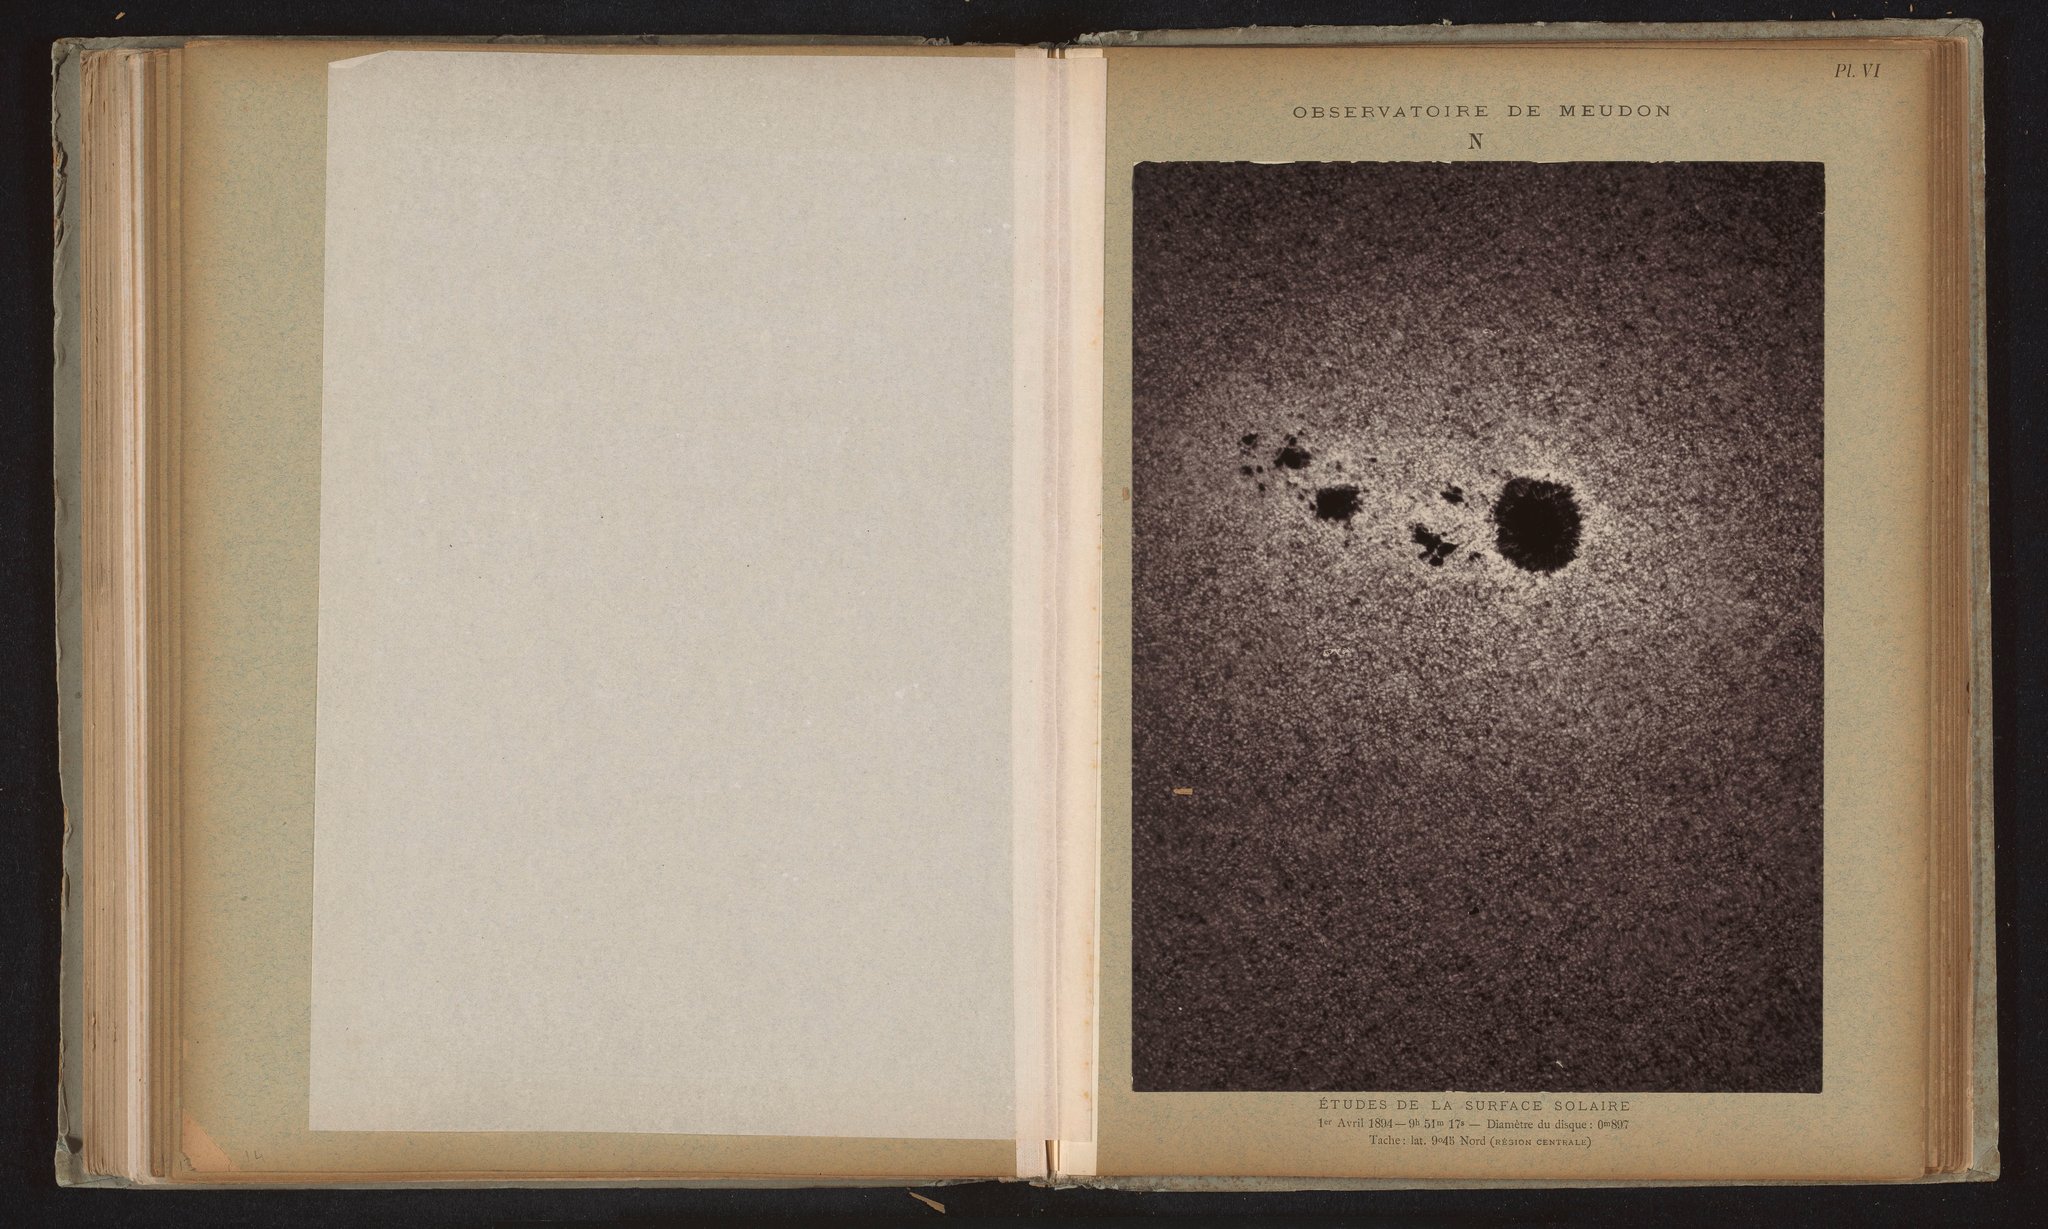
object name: page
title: Observatoire de Meudon - études de la surface solaire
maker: Anonymous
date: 1894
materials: paper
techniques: carbon print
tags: physical aspects of the sun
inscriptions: inscription: ‘1er Avril 1894 - 9h 51m 17s (m), Diamètre du disque: 0m897/ Tache: lat. 9°45 Nord (Région centrale)’, inscription: ‘Pl. VI’